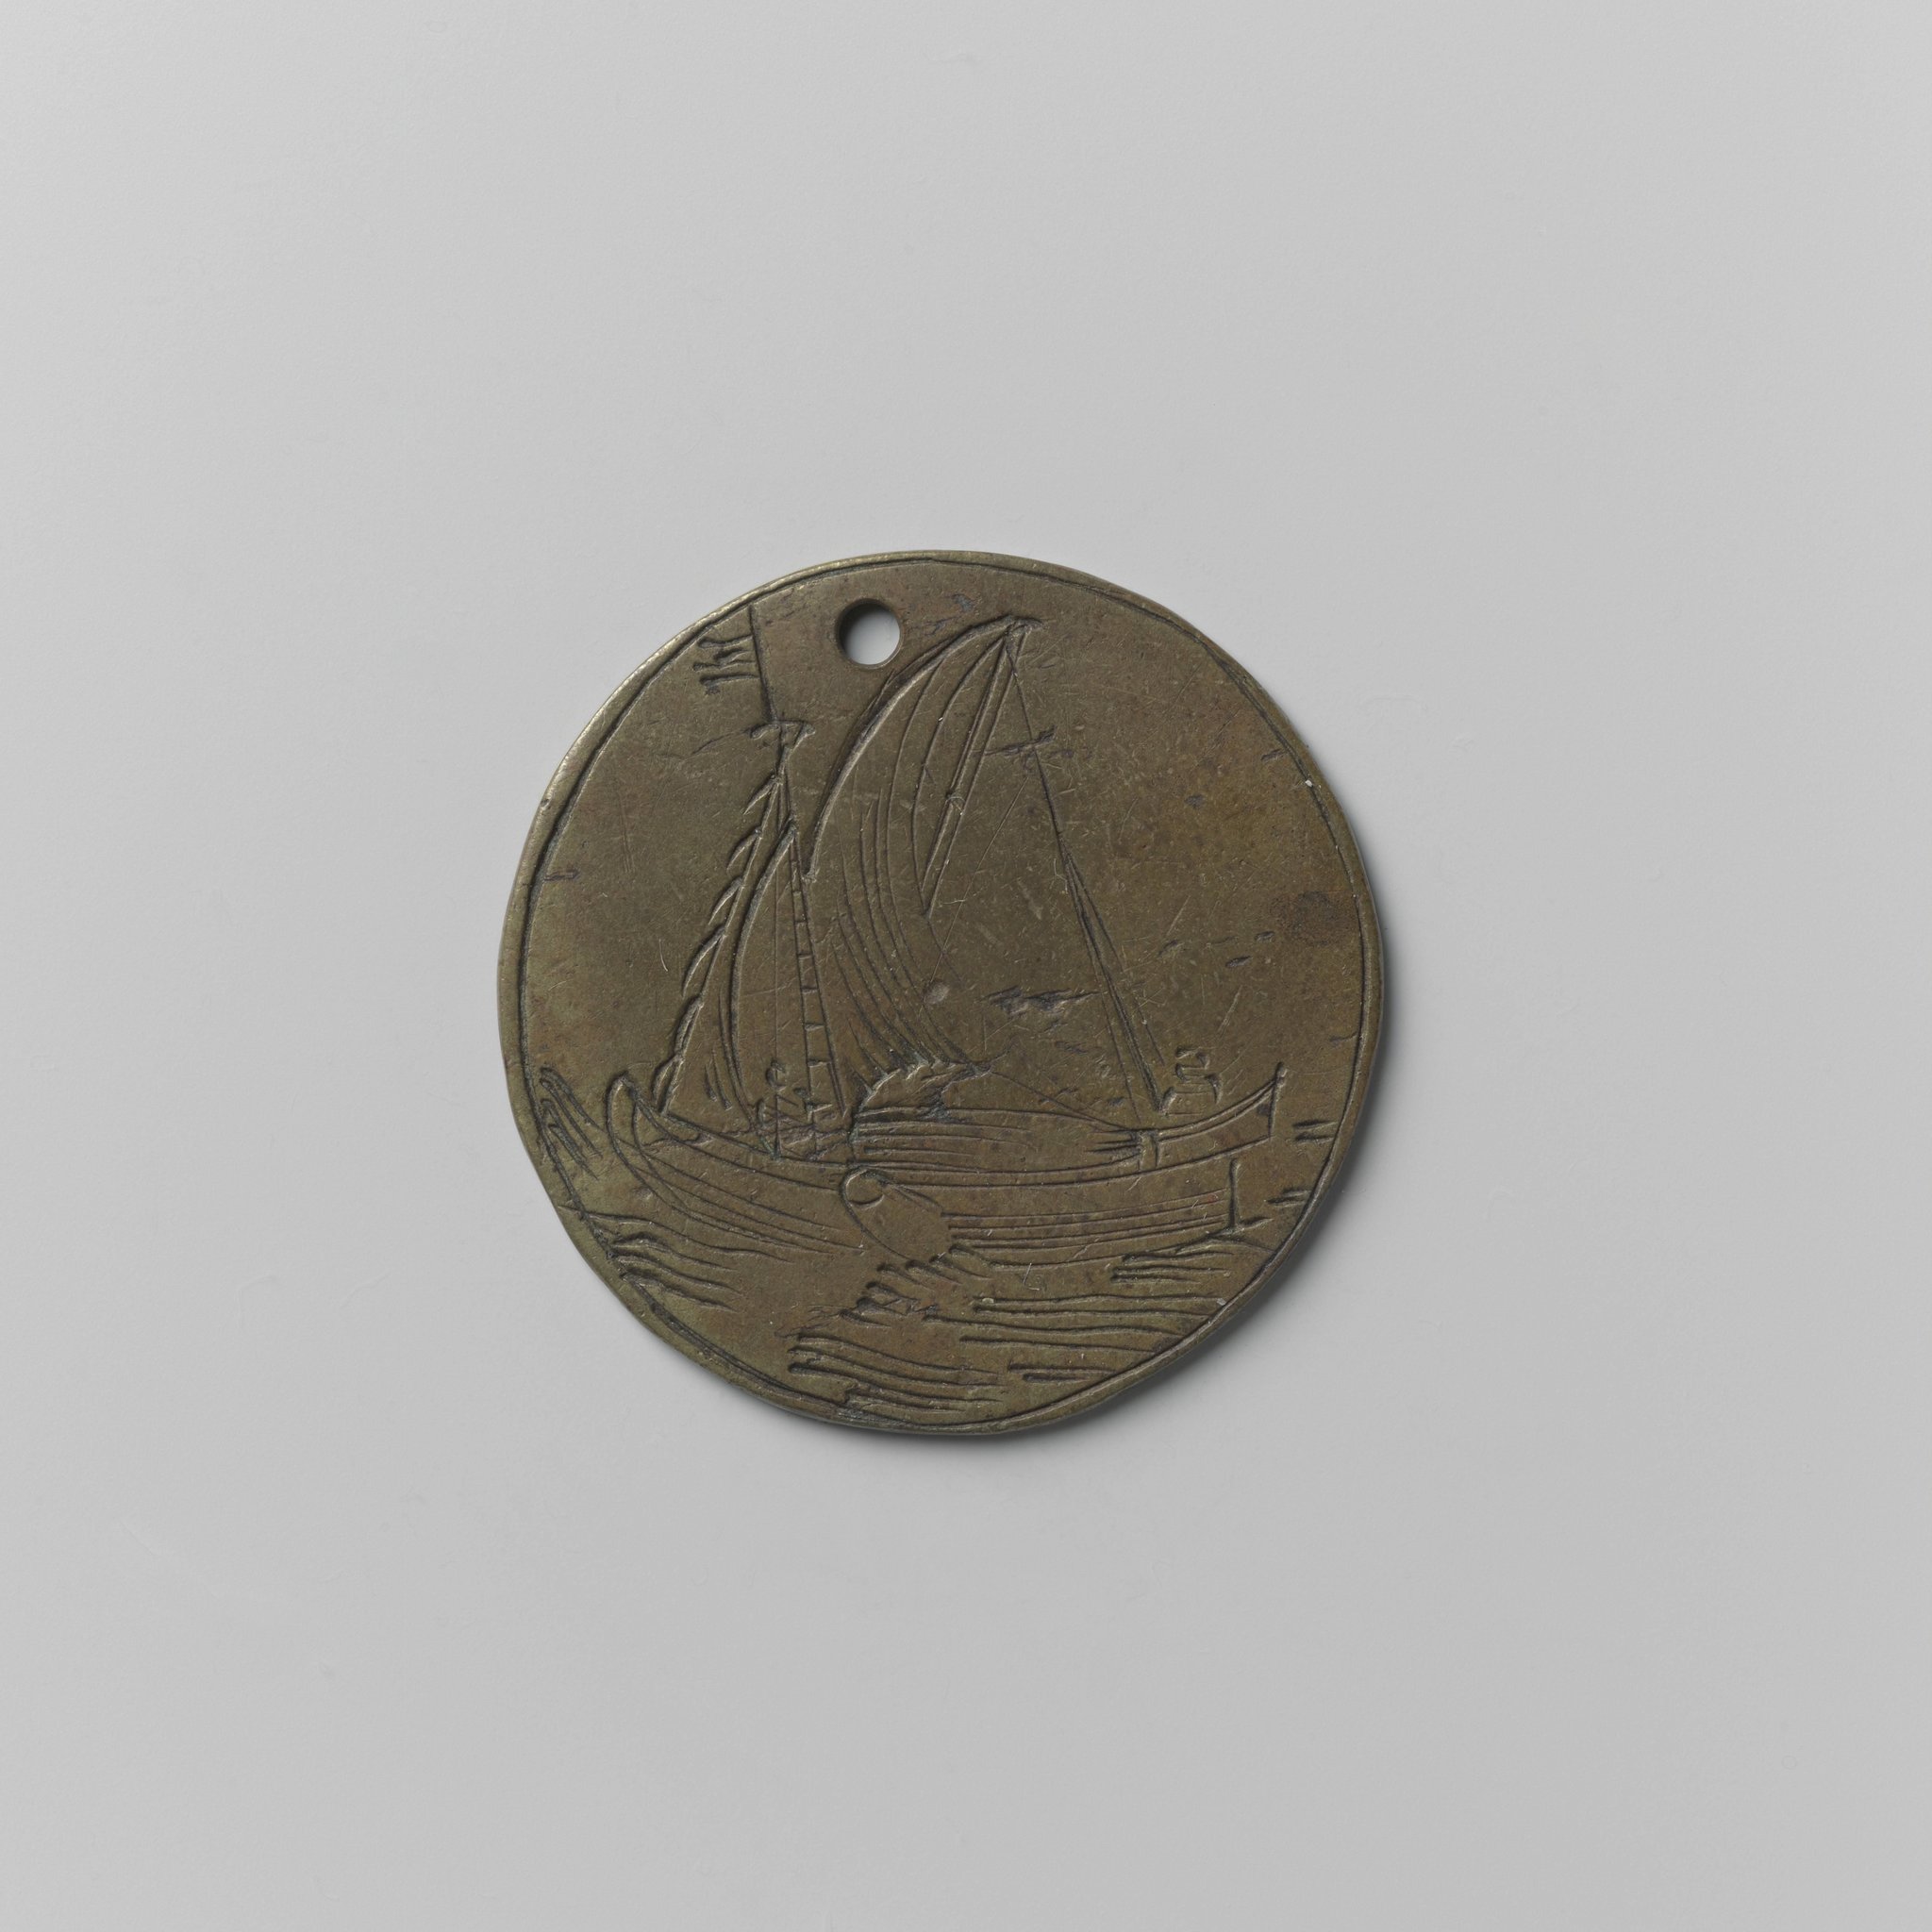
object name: medal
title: Schippersgilde van Amsterdam, gildepenning Arent Hermetesz Vroom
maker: Anonymous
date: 1688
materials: brass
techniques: engraving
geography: amsterdam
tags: amsterdam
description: Messing penning met gat erin. Voorzijde: naar links varend schip; op achterplecht:man. Keerzijde: opschrift.